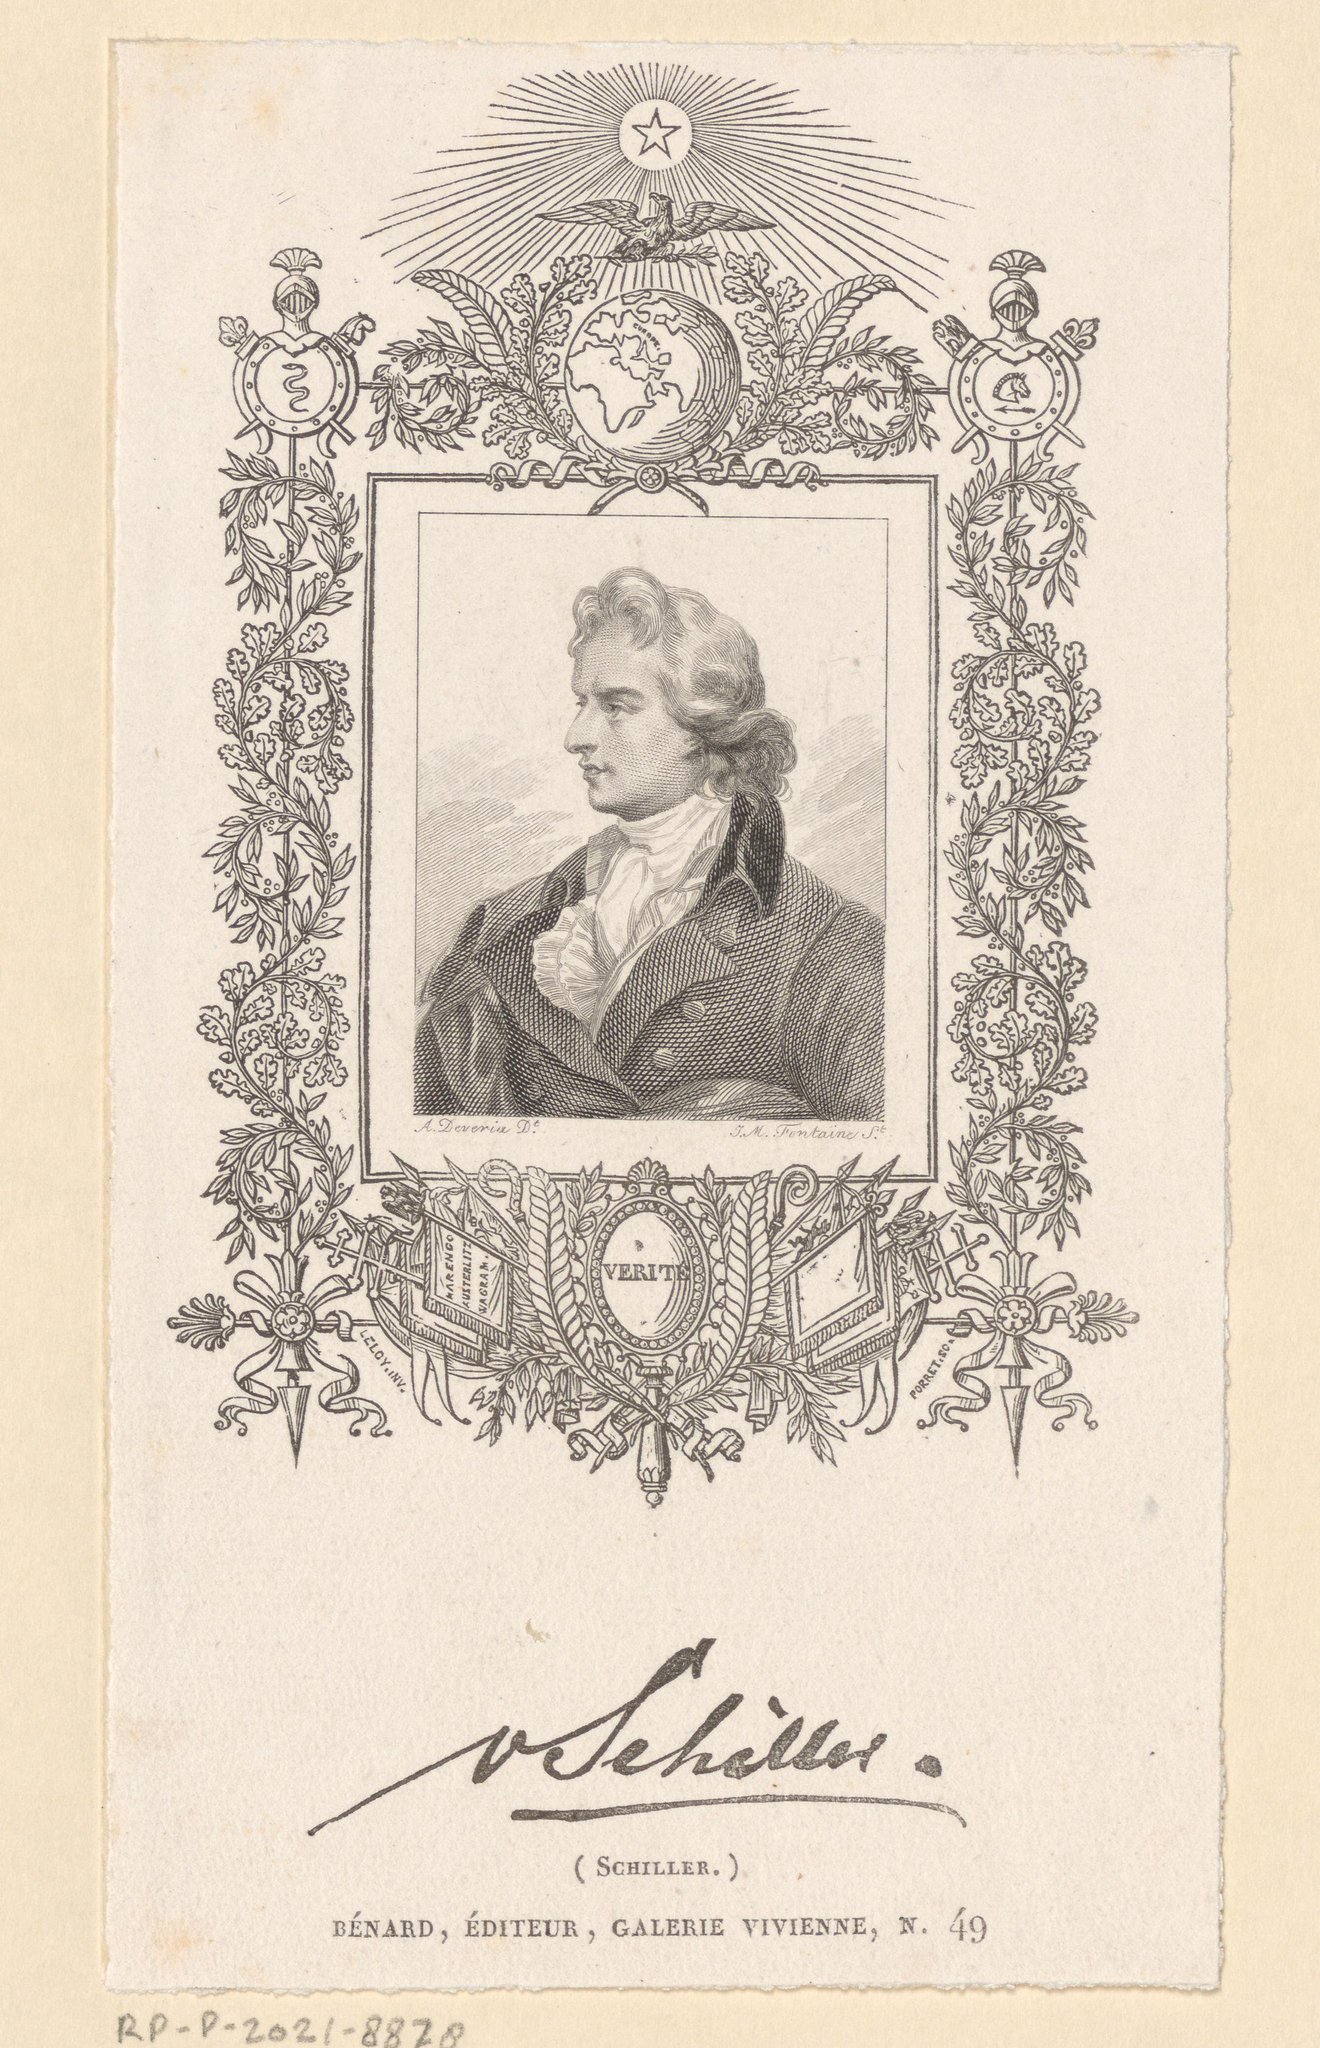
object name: print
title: Galerie Napoléon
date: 1829-1830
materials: paper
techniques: engraving, letterpress printing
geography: paris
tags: friedrich von schiller, scholar, philosopher, historical persons, portrait of a writer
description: Dit portret maakt deel uit van de serie 'Galerie Napoléon', een collectie van honderd portretten van vooraanstaande figuren uit de omgeving van Napoleon Bonaparte. De serie werd uitgegeven door Bénard in Parijs in 1829-30.